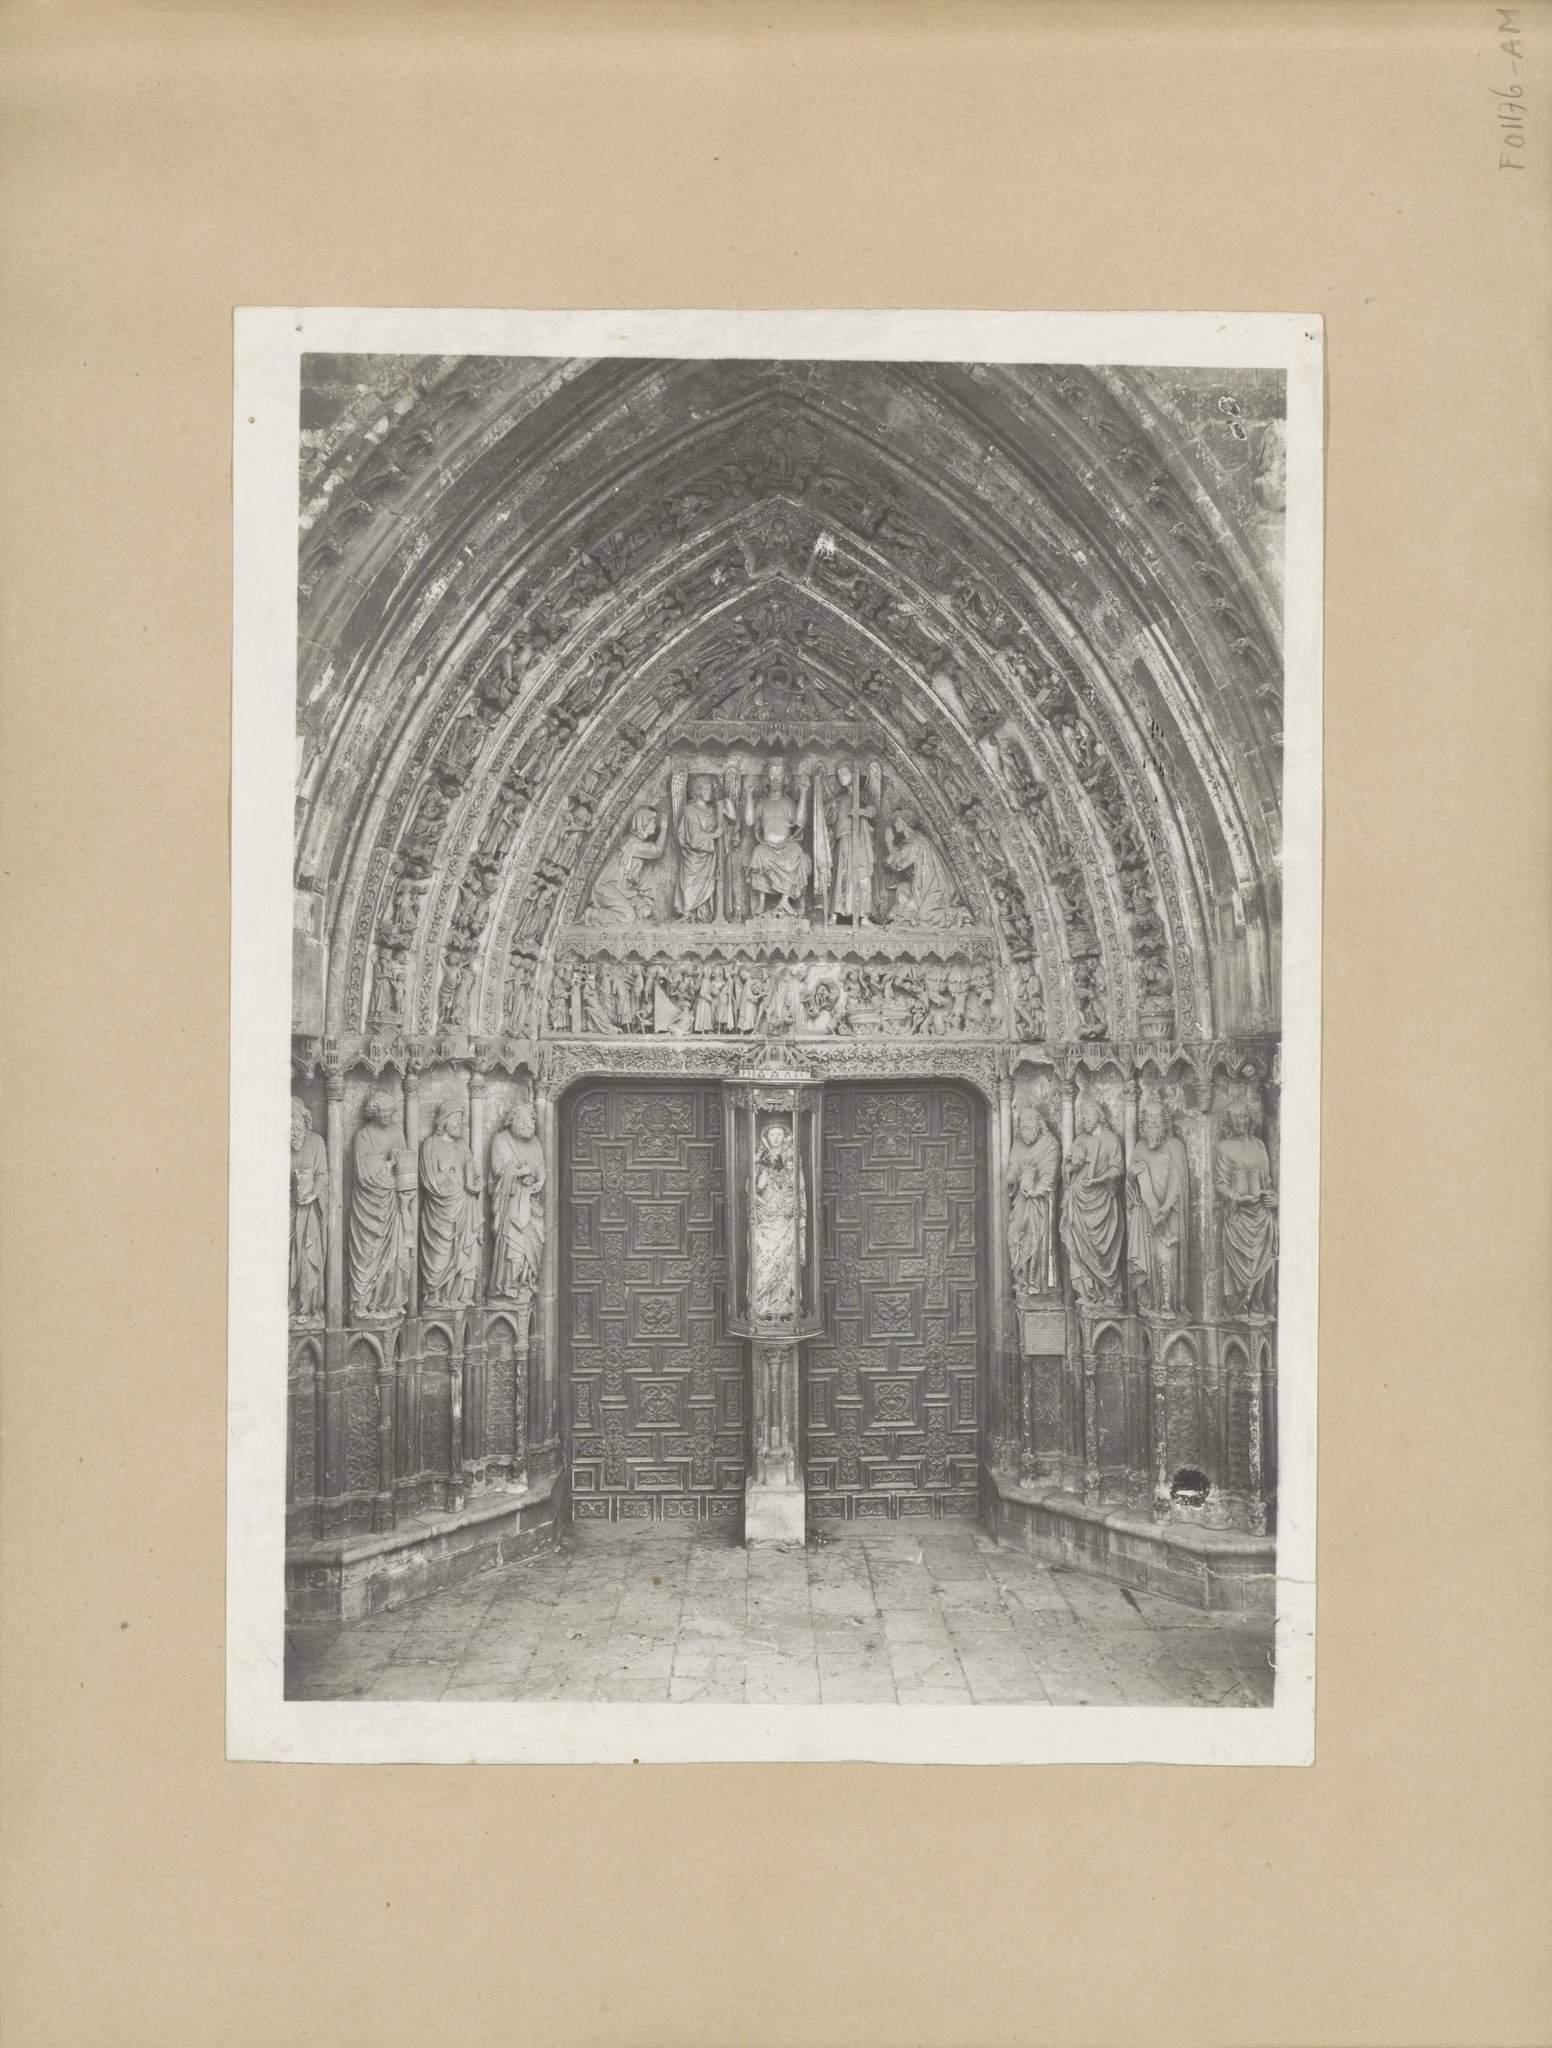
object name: photograph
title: Kerkportaal met sculpturen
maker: Anonymous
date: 1850-1876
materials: cardboard, photographic support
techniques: gelatin silver print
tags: parts of church exterior and annexes: portal, piece of sculpture, reproduction of a piece of sculpture (+ sculpture), travelling; tourism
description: Onderdeel van Reisalbum met foto's en tekeningen van Manuel Mayo 1876.